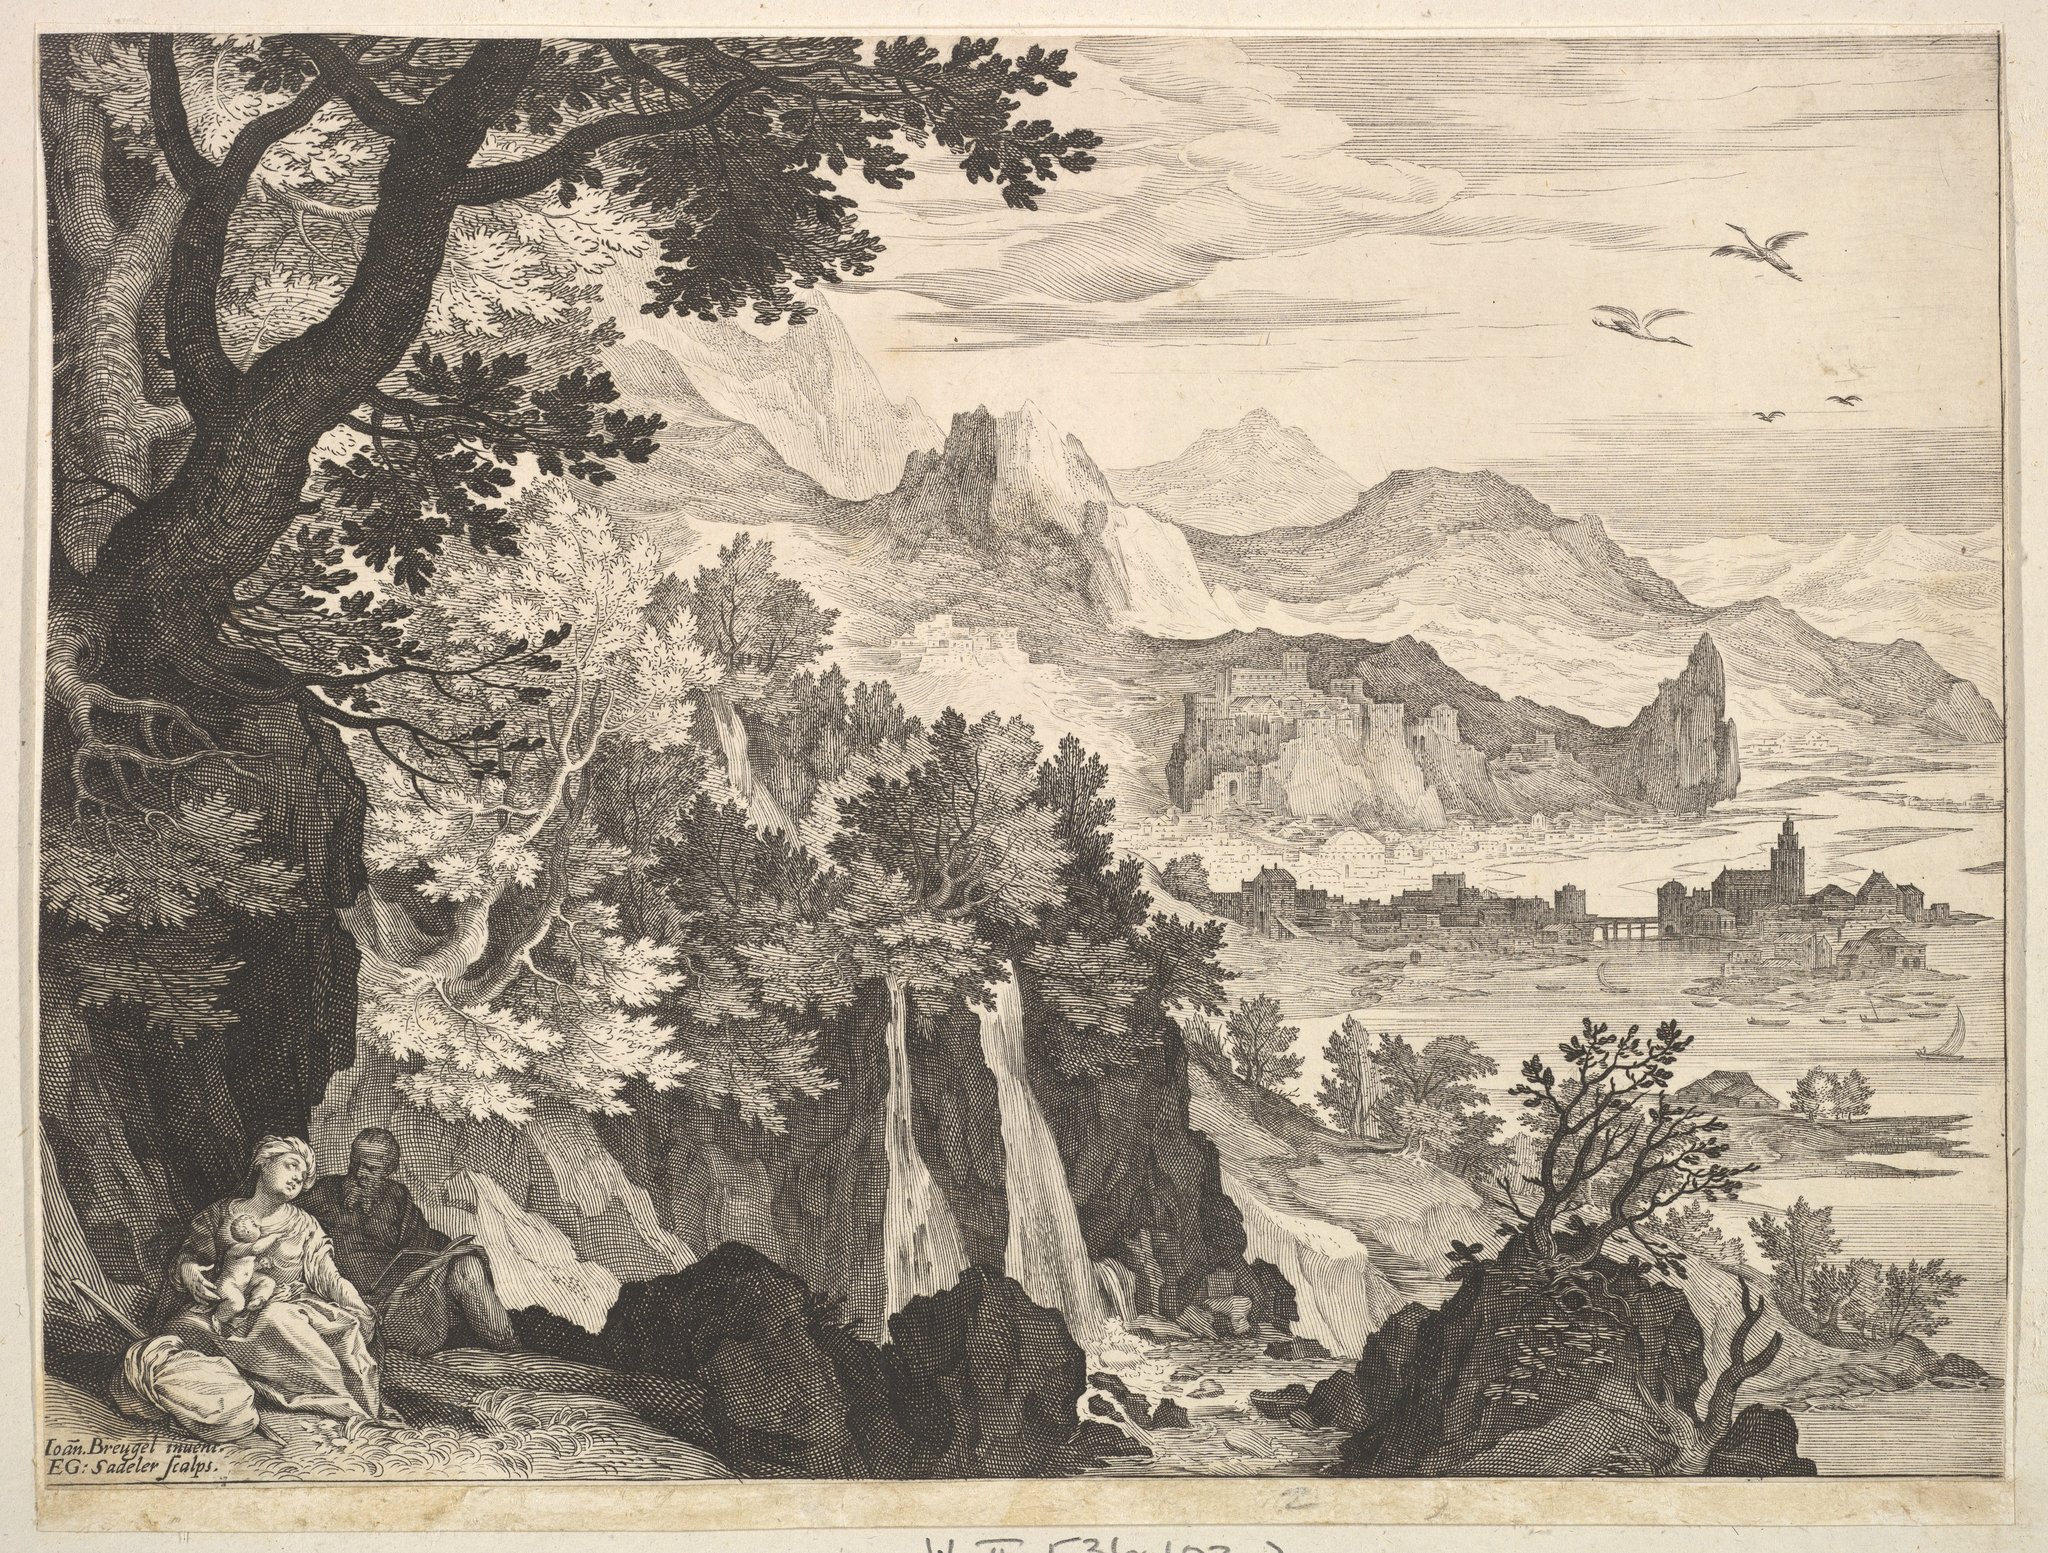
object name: print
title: Mountainous Landscape with the Rest on the Flight into Egypt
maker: aegidius sadeler (ii)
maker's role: artist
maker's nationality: flemish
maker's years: 1568-1629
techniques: engraving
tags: men,women,mountains,landscapes,trees